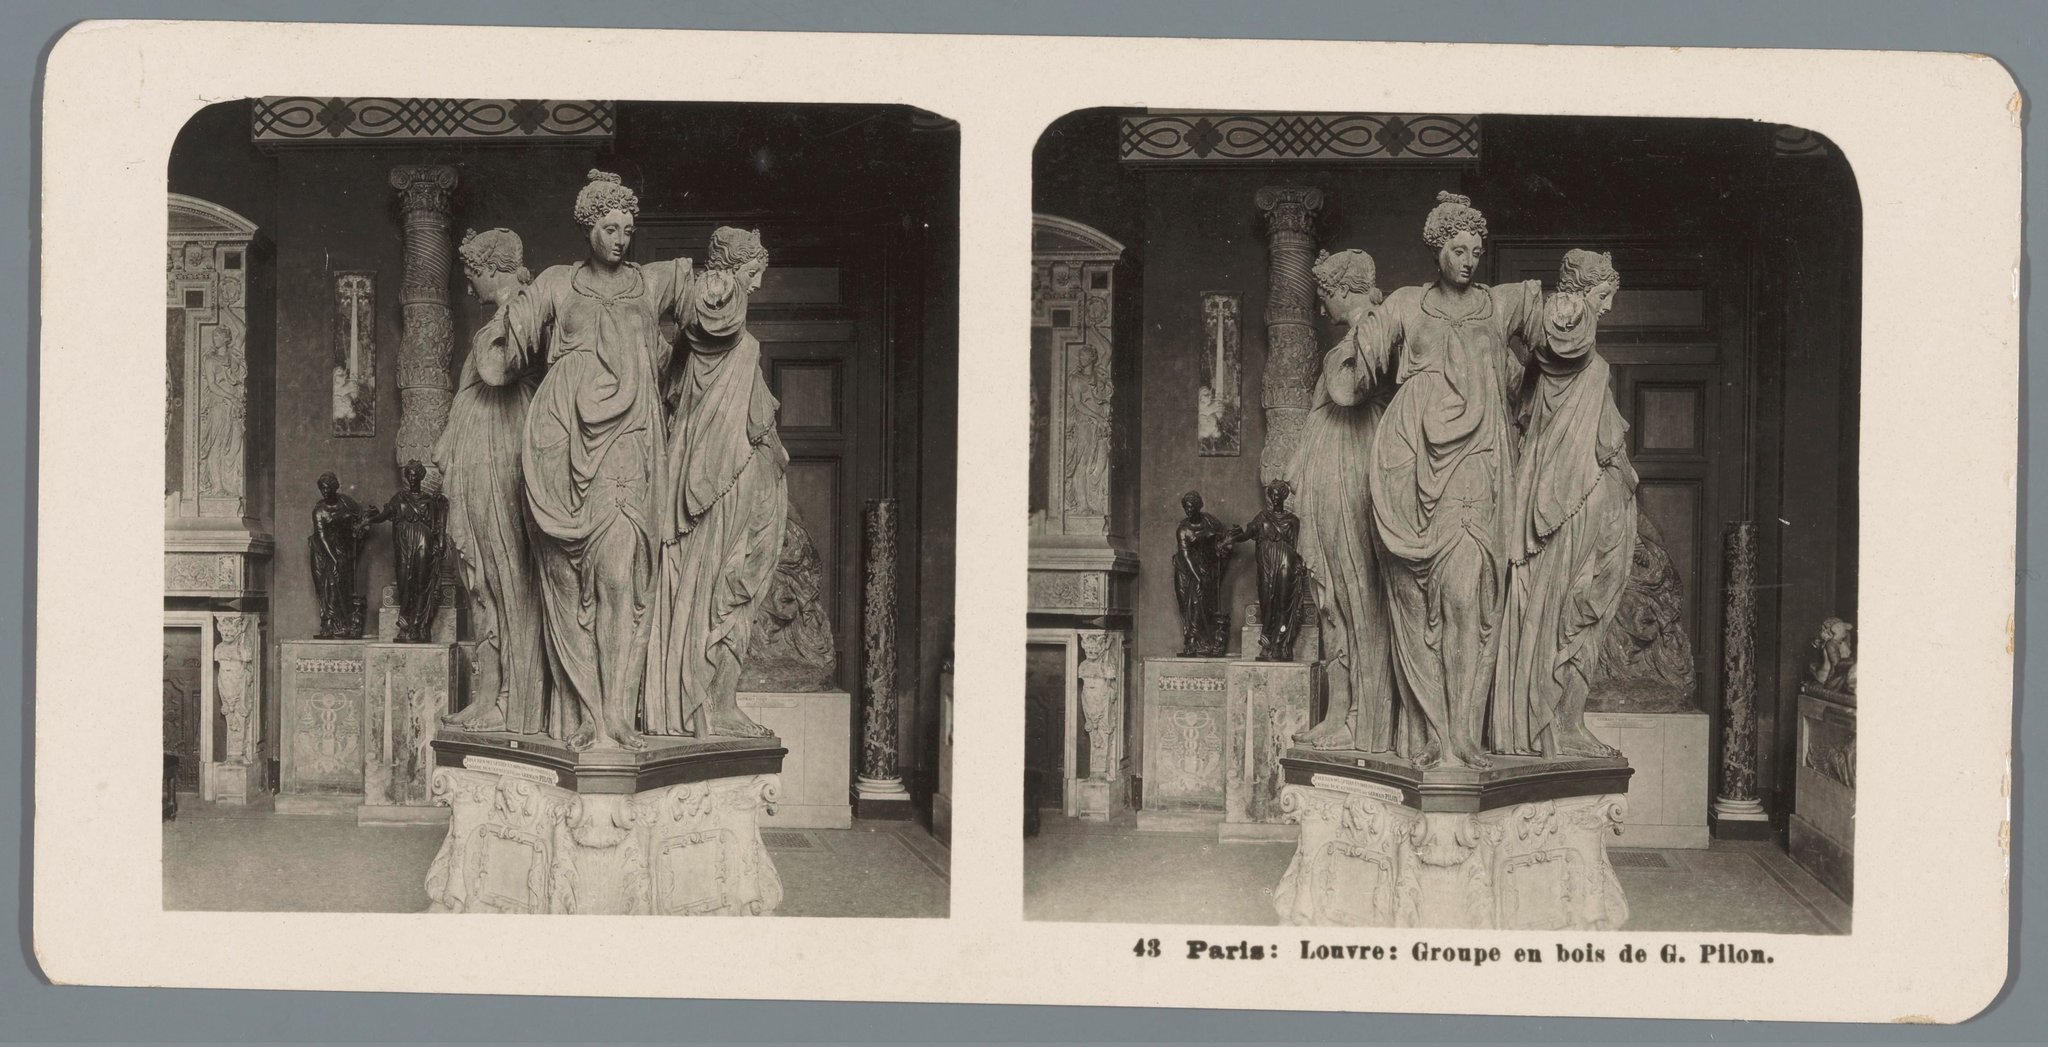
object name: stereograph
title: Paris: Louvre: Groupe en bois de G. Pilon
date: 1904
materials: cardboard, photographic support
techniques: gelatin silver print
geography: louvre museum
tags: adult woman, permanent exhibition, museum, sculpture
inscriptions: number: ‘40’, inscription: ‘Neue Photographische Gesellschaft A.-G. Steglitz-Berlin 1904.’